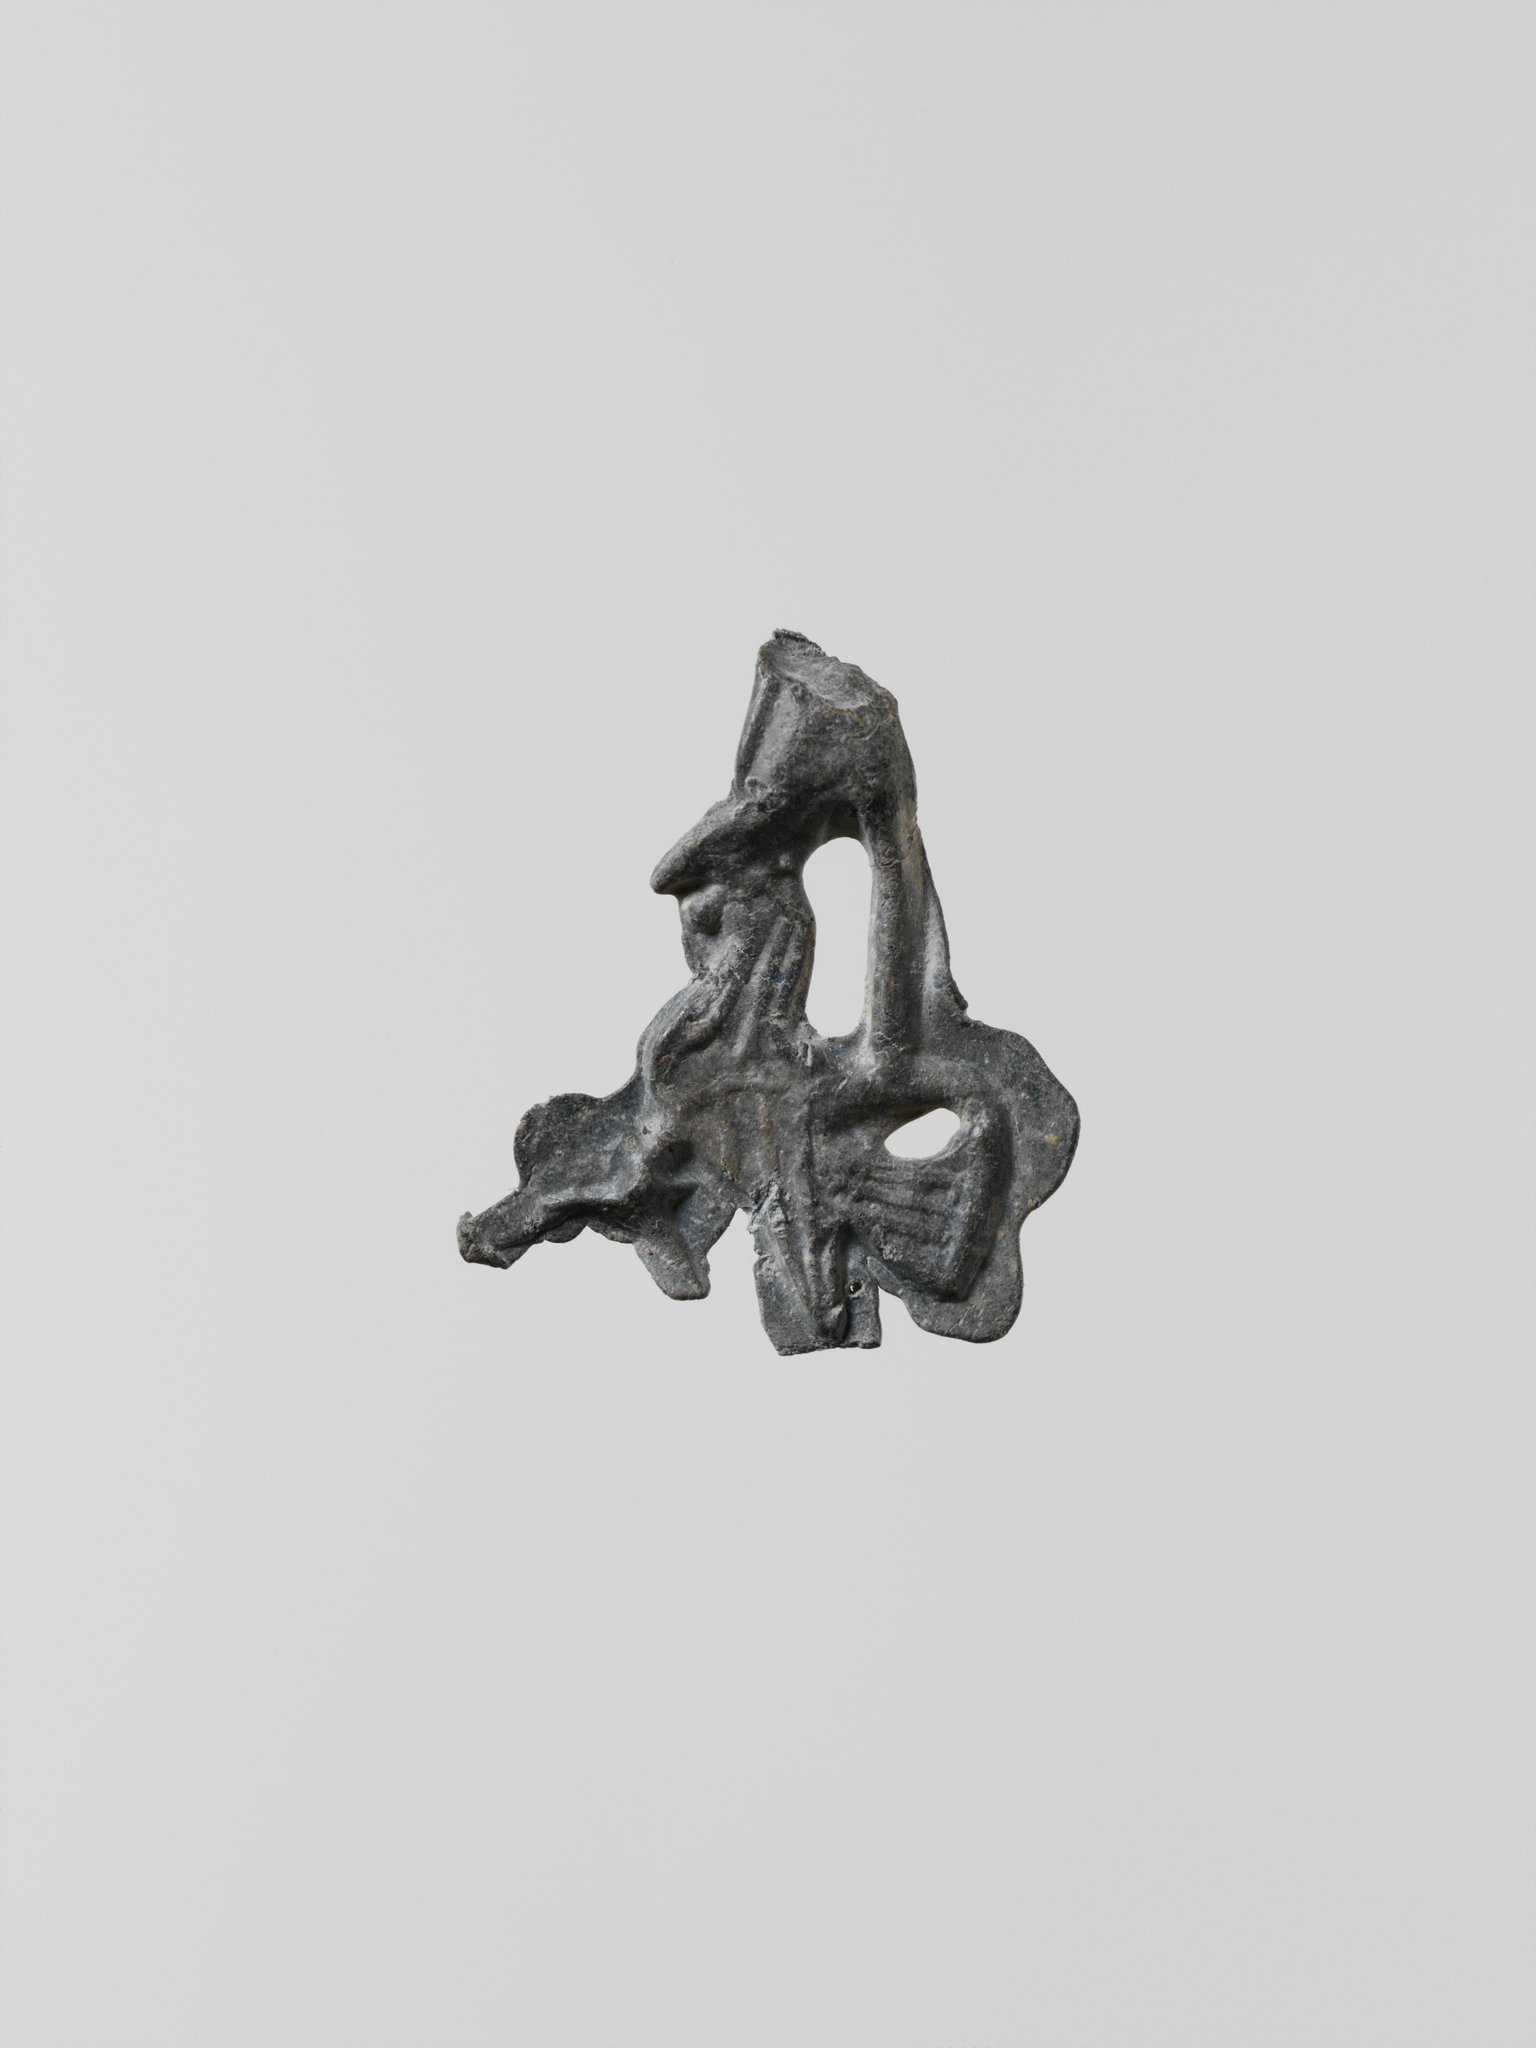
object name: statuette of a cock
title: Statuette of a cock, 2?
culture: greek, laconian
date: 7000-30 BCE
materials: lead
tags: roosters